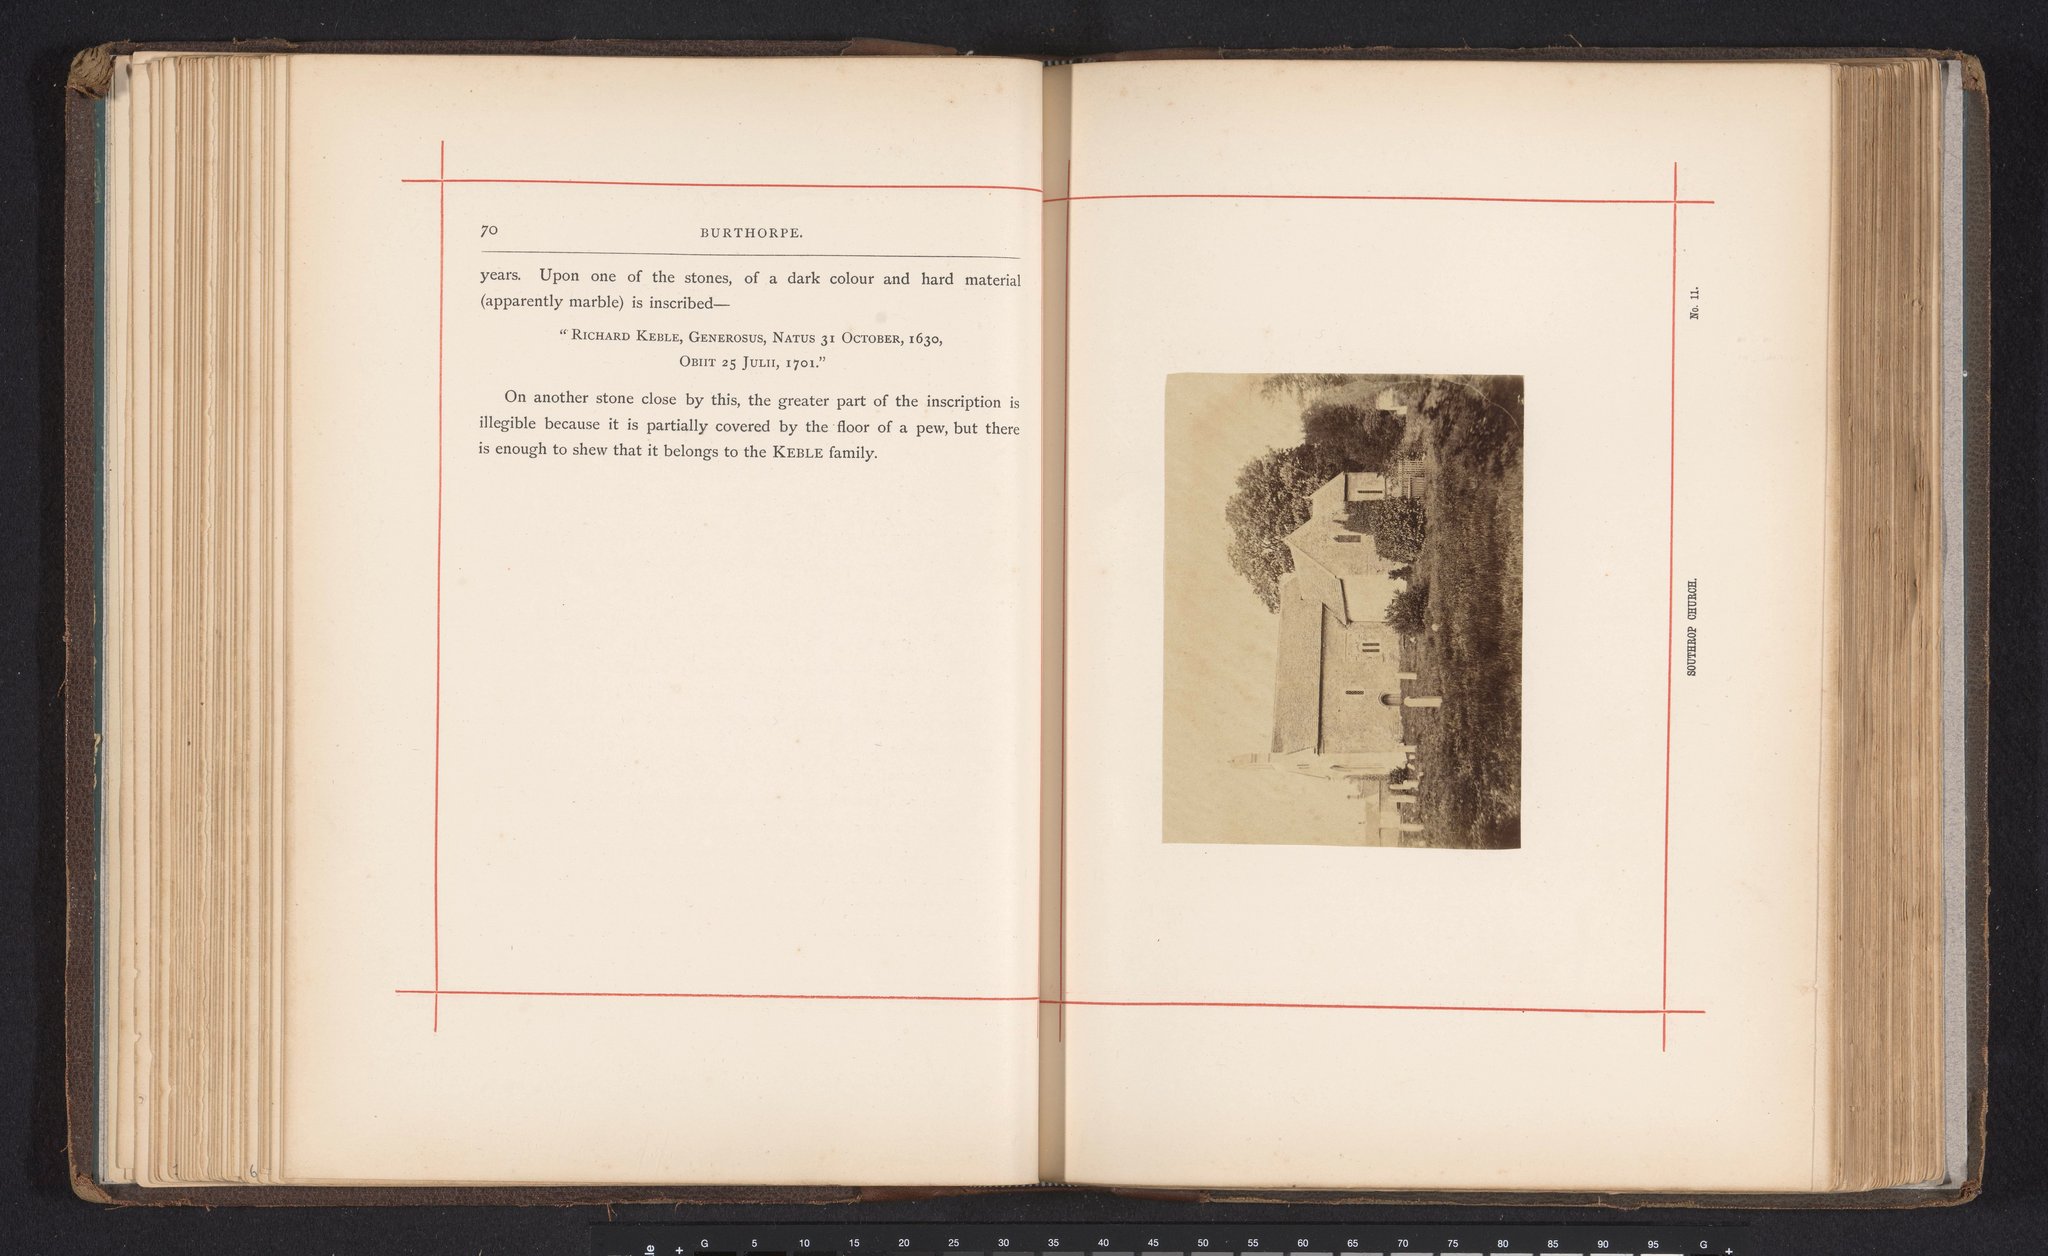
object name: photograph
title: Southrop Church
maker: william savage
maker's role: fotograaf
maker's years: 1817-1887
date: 1861-1866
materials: paper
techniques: albumen print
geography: southrop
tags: church (exterior)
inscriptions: number: ‘No. 11.’